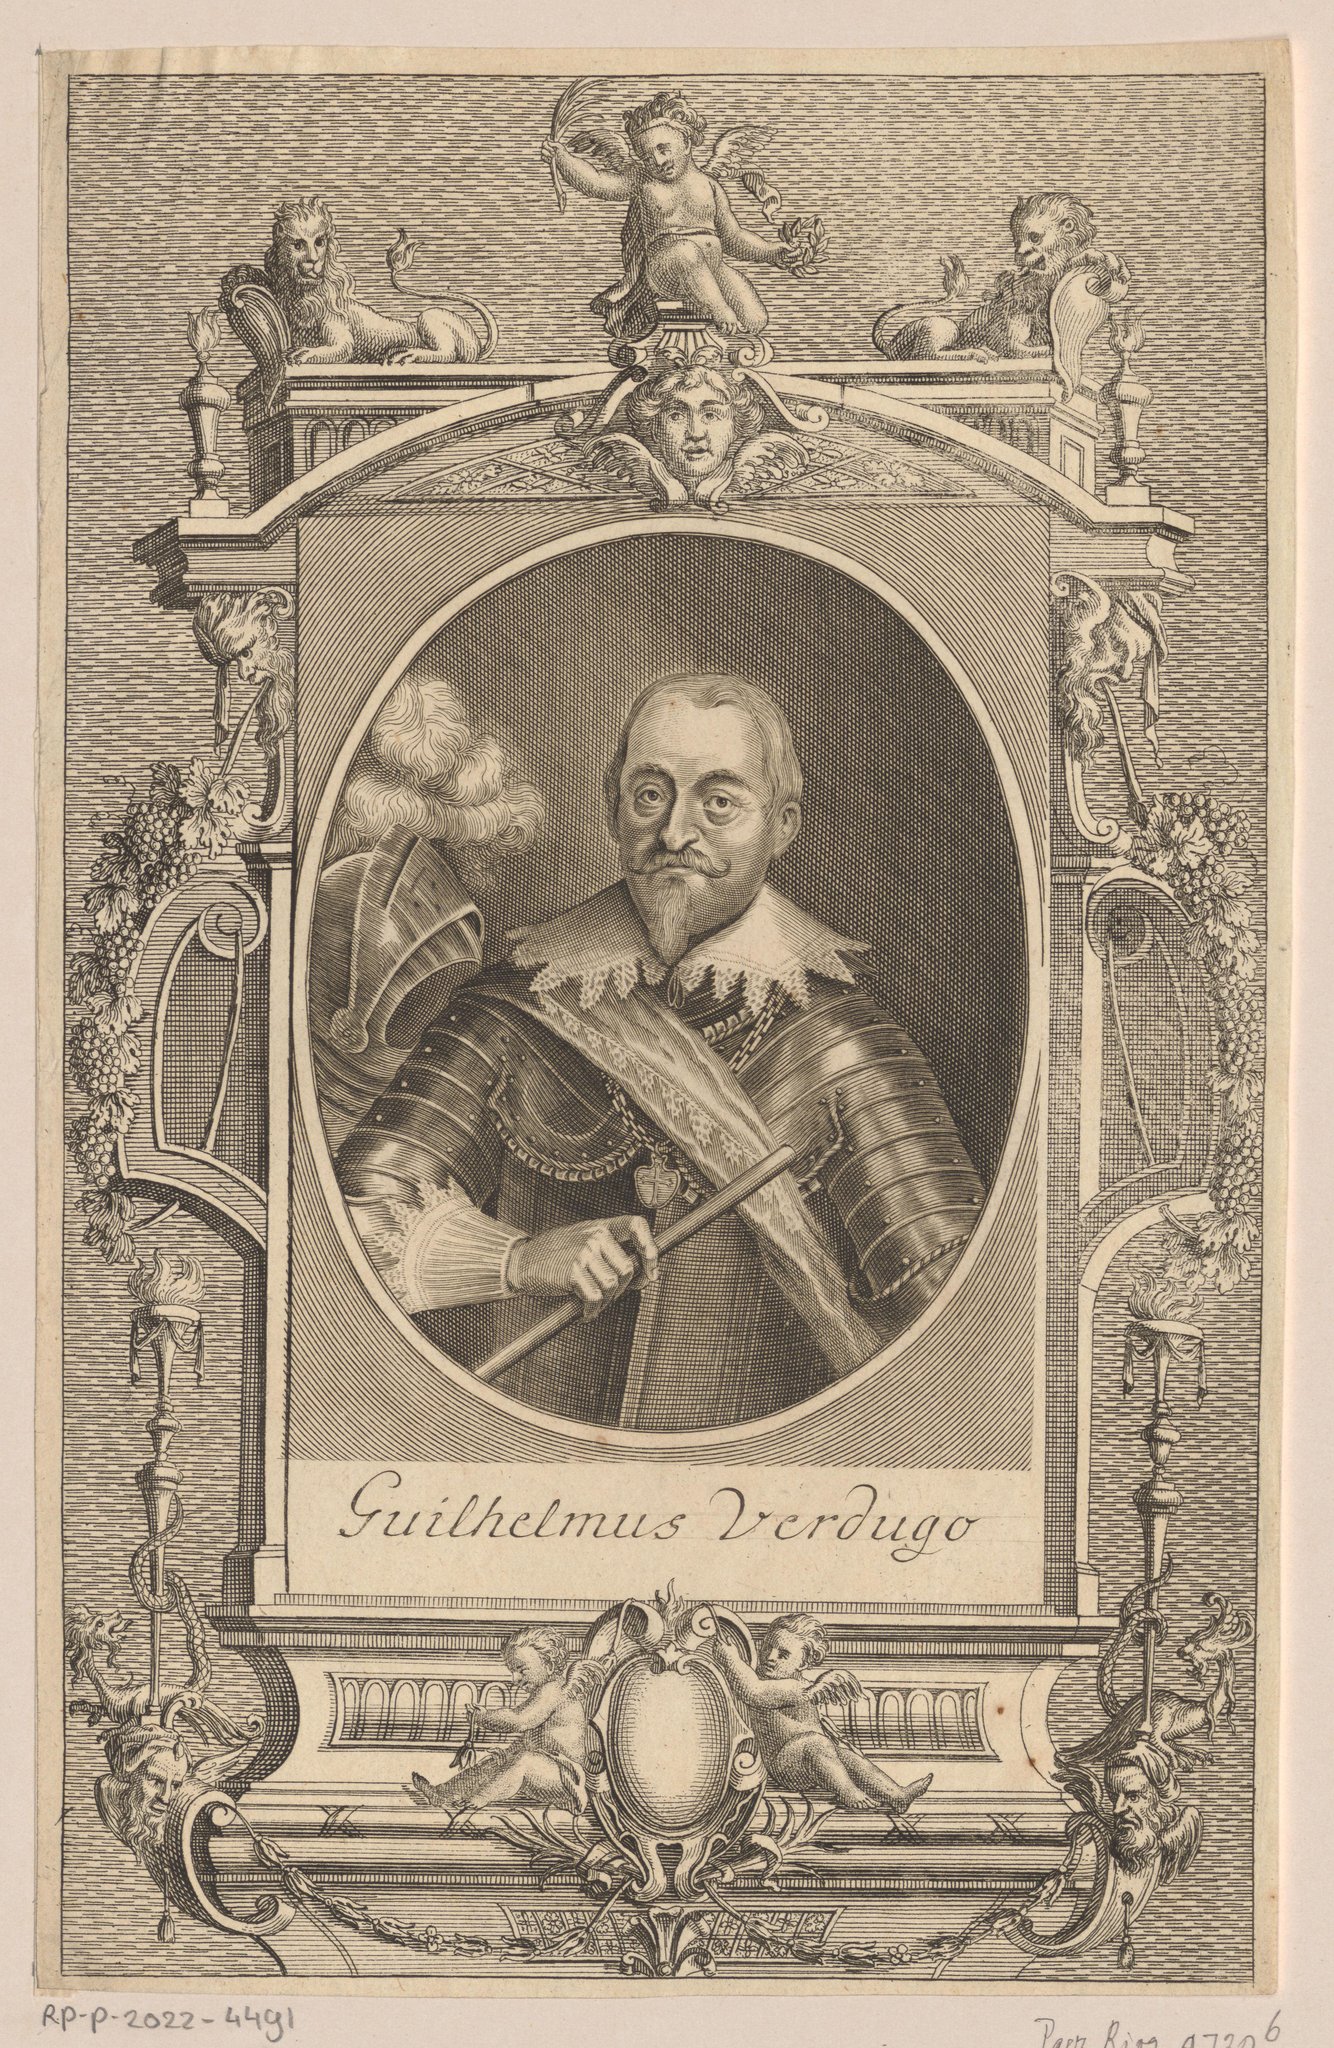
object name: print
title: Portret van Wilhelm Verdugo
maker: Anonymous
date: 1722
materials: paper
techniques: engraving, etching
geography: germany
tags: armour, historical persons, ornament derived from architectural details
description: Prent uit: Khevenhüller, Franz Christoph. Conterfet Kupfferstich (...). Leipzig: Moritz Georg Weidmann, 1722, dl. 2, p. 412.